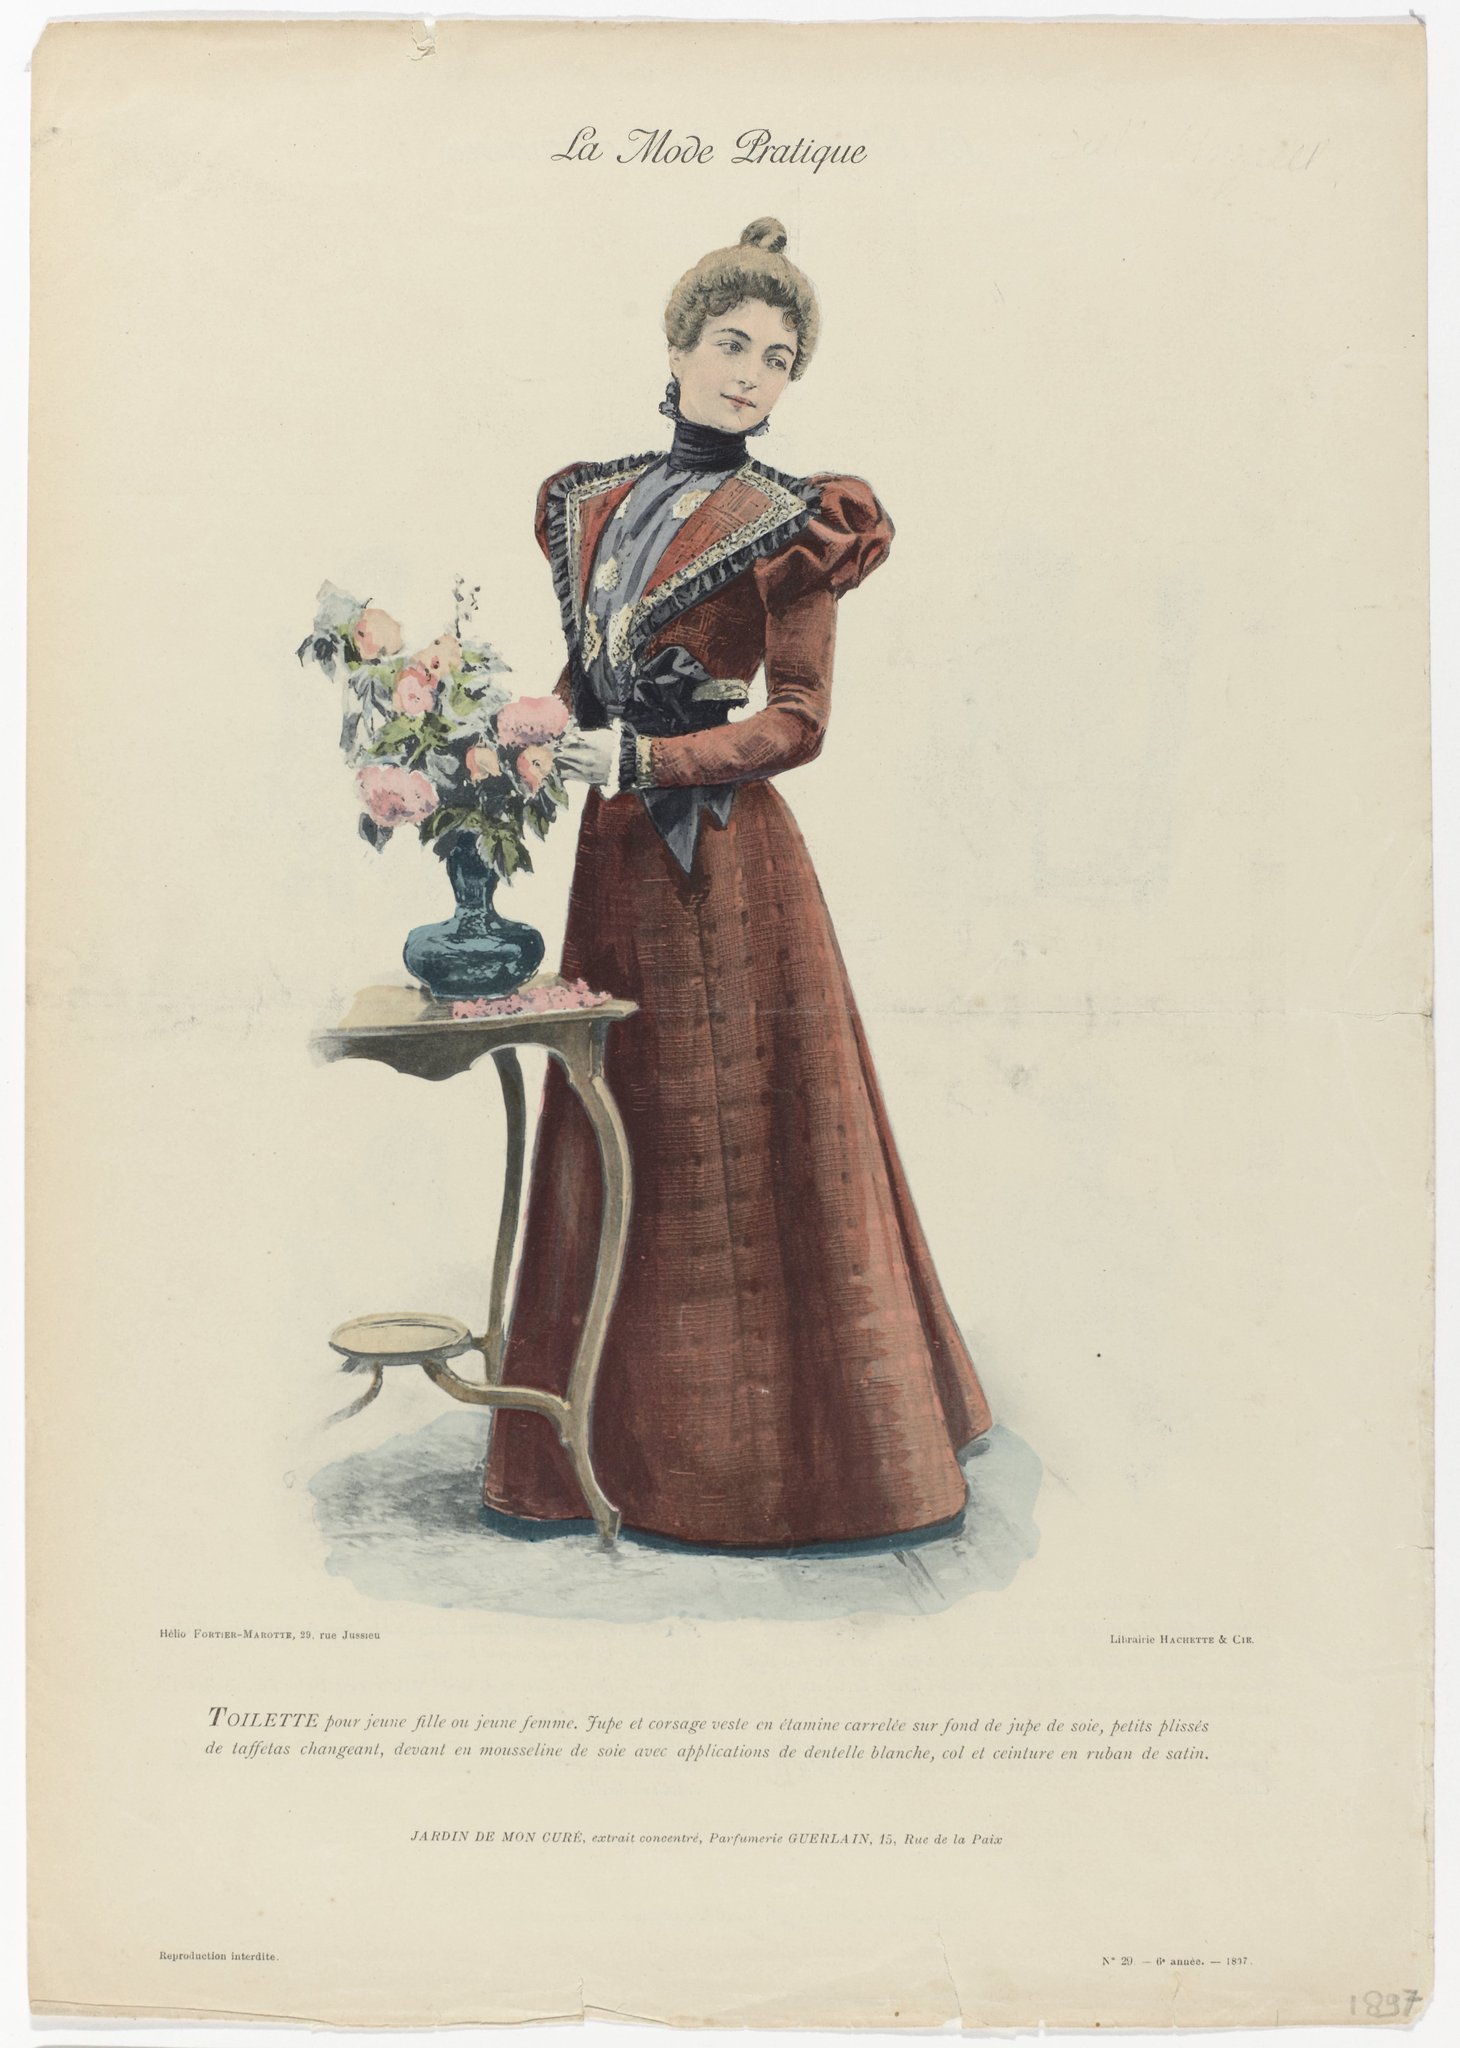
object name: fashion print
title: Le Mode Pratique, 1897, No. 29, 6e année : Toilette pour jeune fill (...)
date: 1897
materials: paper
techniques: printing, photography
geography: paris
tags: flowers, clothing for the upper part of the body (+ women's clothes), border, ribbon, braid (+ women's clothes), lace (+ women's clothes), arranging flowers, neck-gear: collar (+ women's clothes), fashion plates, skirt (+ women's clothes), belt, girdle, waistband (+ women's clothes)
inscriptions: caption: ‘Toilette pour jeune fille ou jeune femme. Jupe et corsage veste en étamine carrelée sur fond de jupe de soie, petits plissés de taffetas changeant, edvant en mousseline de soie avec applications de dentelle blanche, col et ceinture en ruban de satin. / JARDIN DE MON CURÉ, extrait concentré, Parfumerie GUERLAIN, 15, Rue de la Paix’, title: ‘La Mode Pratique’